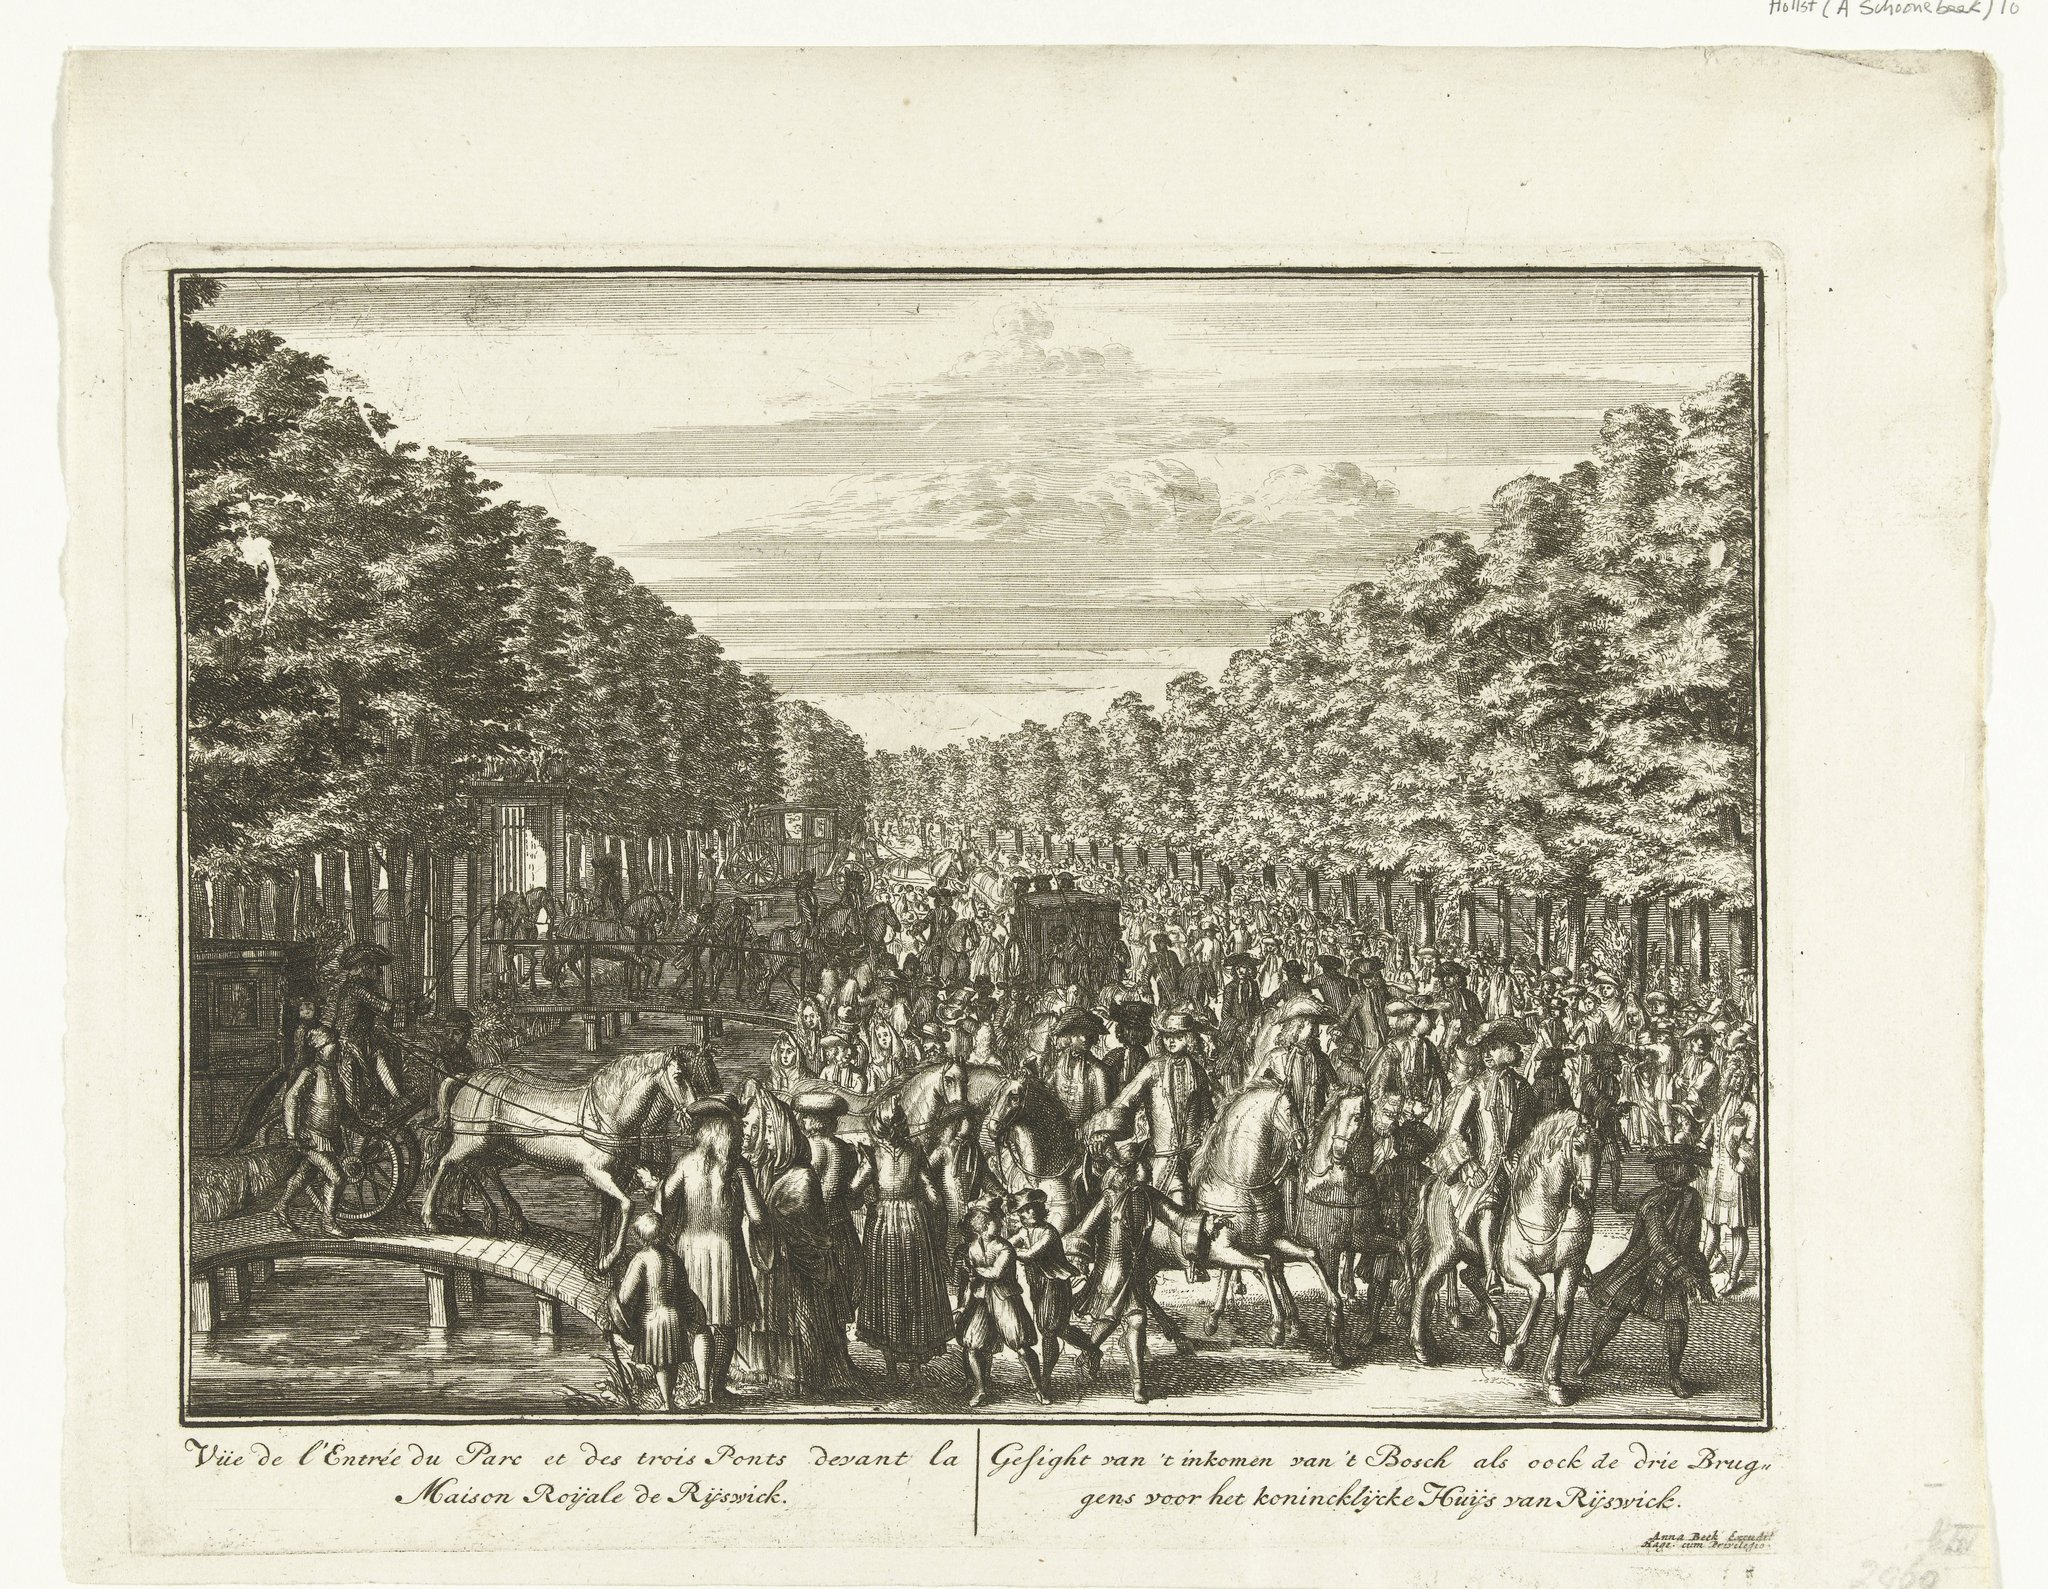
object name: print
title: Boslaan met de drie bruggen voor het Huis ter Nieuburch in Rijswijk, 1697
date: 1697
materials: paper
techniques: etching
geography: the hague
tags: palace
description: Boslaan met de drie bruggen met koetsen en veel publiek voor het Huis ter Nieuburch in Rijswijk. In het onderschrift de twee titels in het Frans en Nederlands. Onderdeel van de serie van vijftien prenten over het Huis ter Nieuburch in Rijswijk en de daar gehouden vredesonderhandelingen resulterend in de Vrede van Rijswijk gesloten op 20 september 1697.